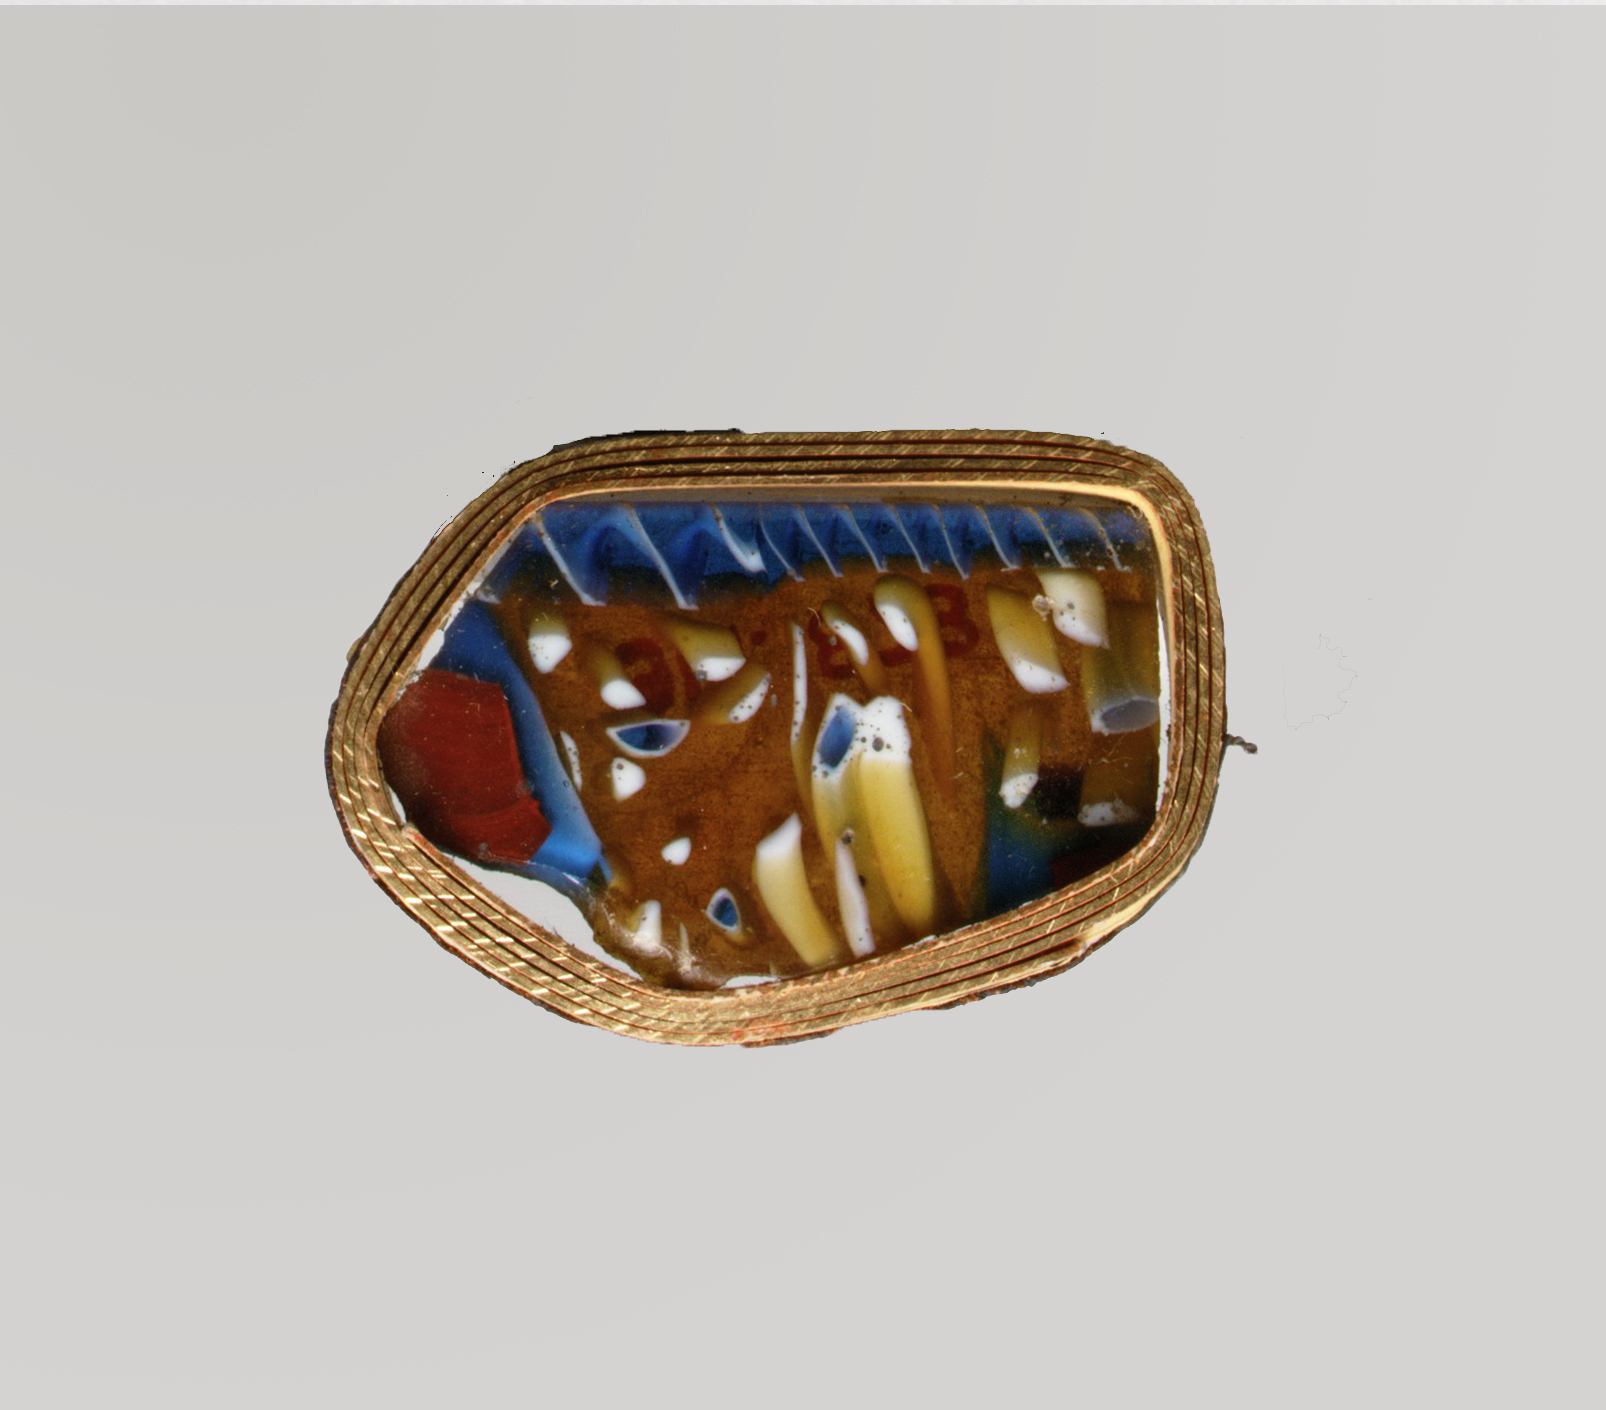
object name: fragment, mosaic bowl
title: Glass mosaic bowl fragment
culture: roman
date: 34 BCE-33 CE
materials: glass